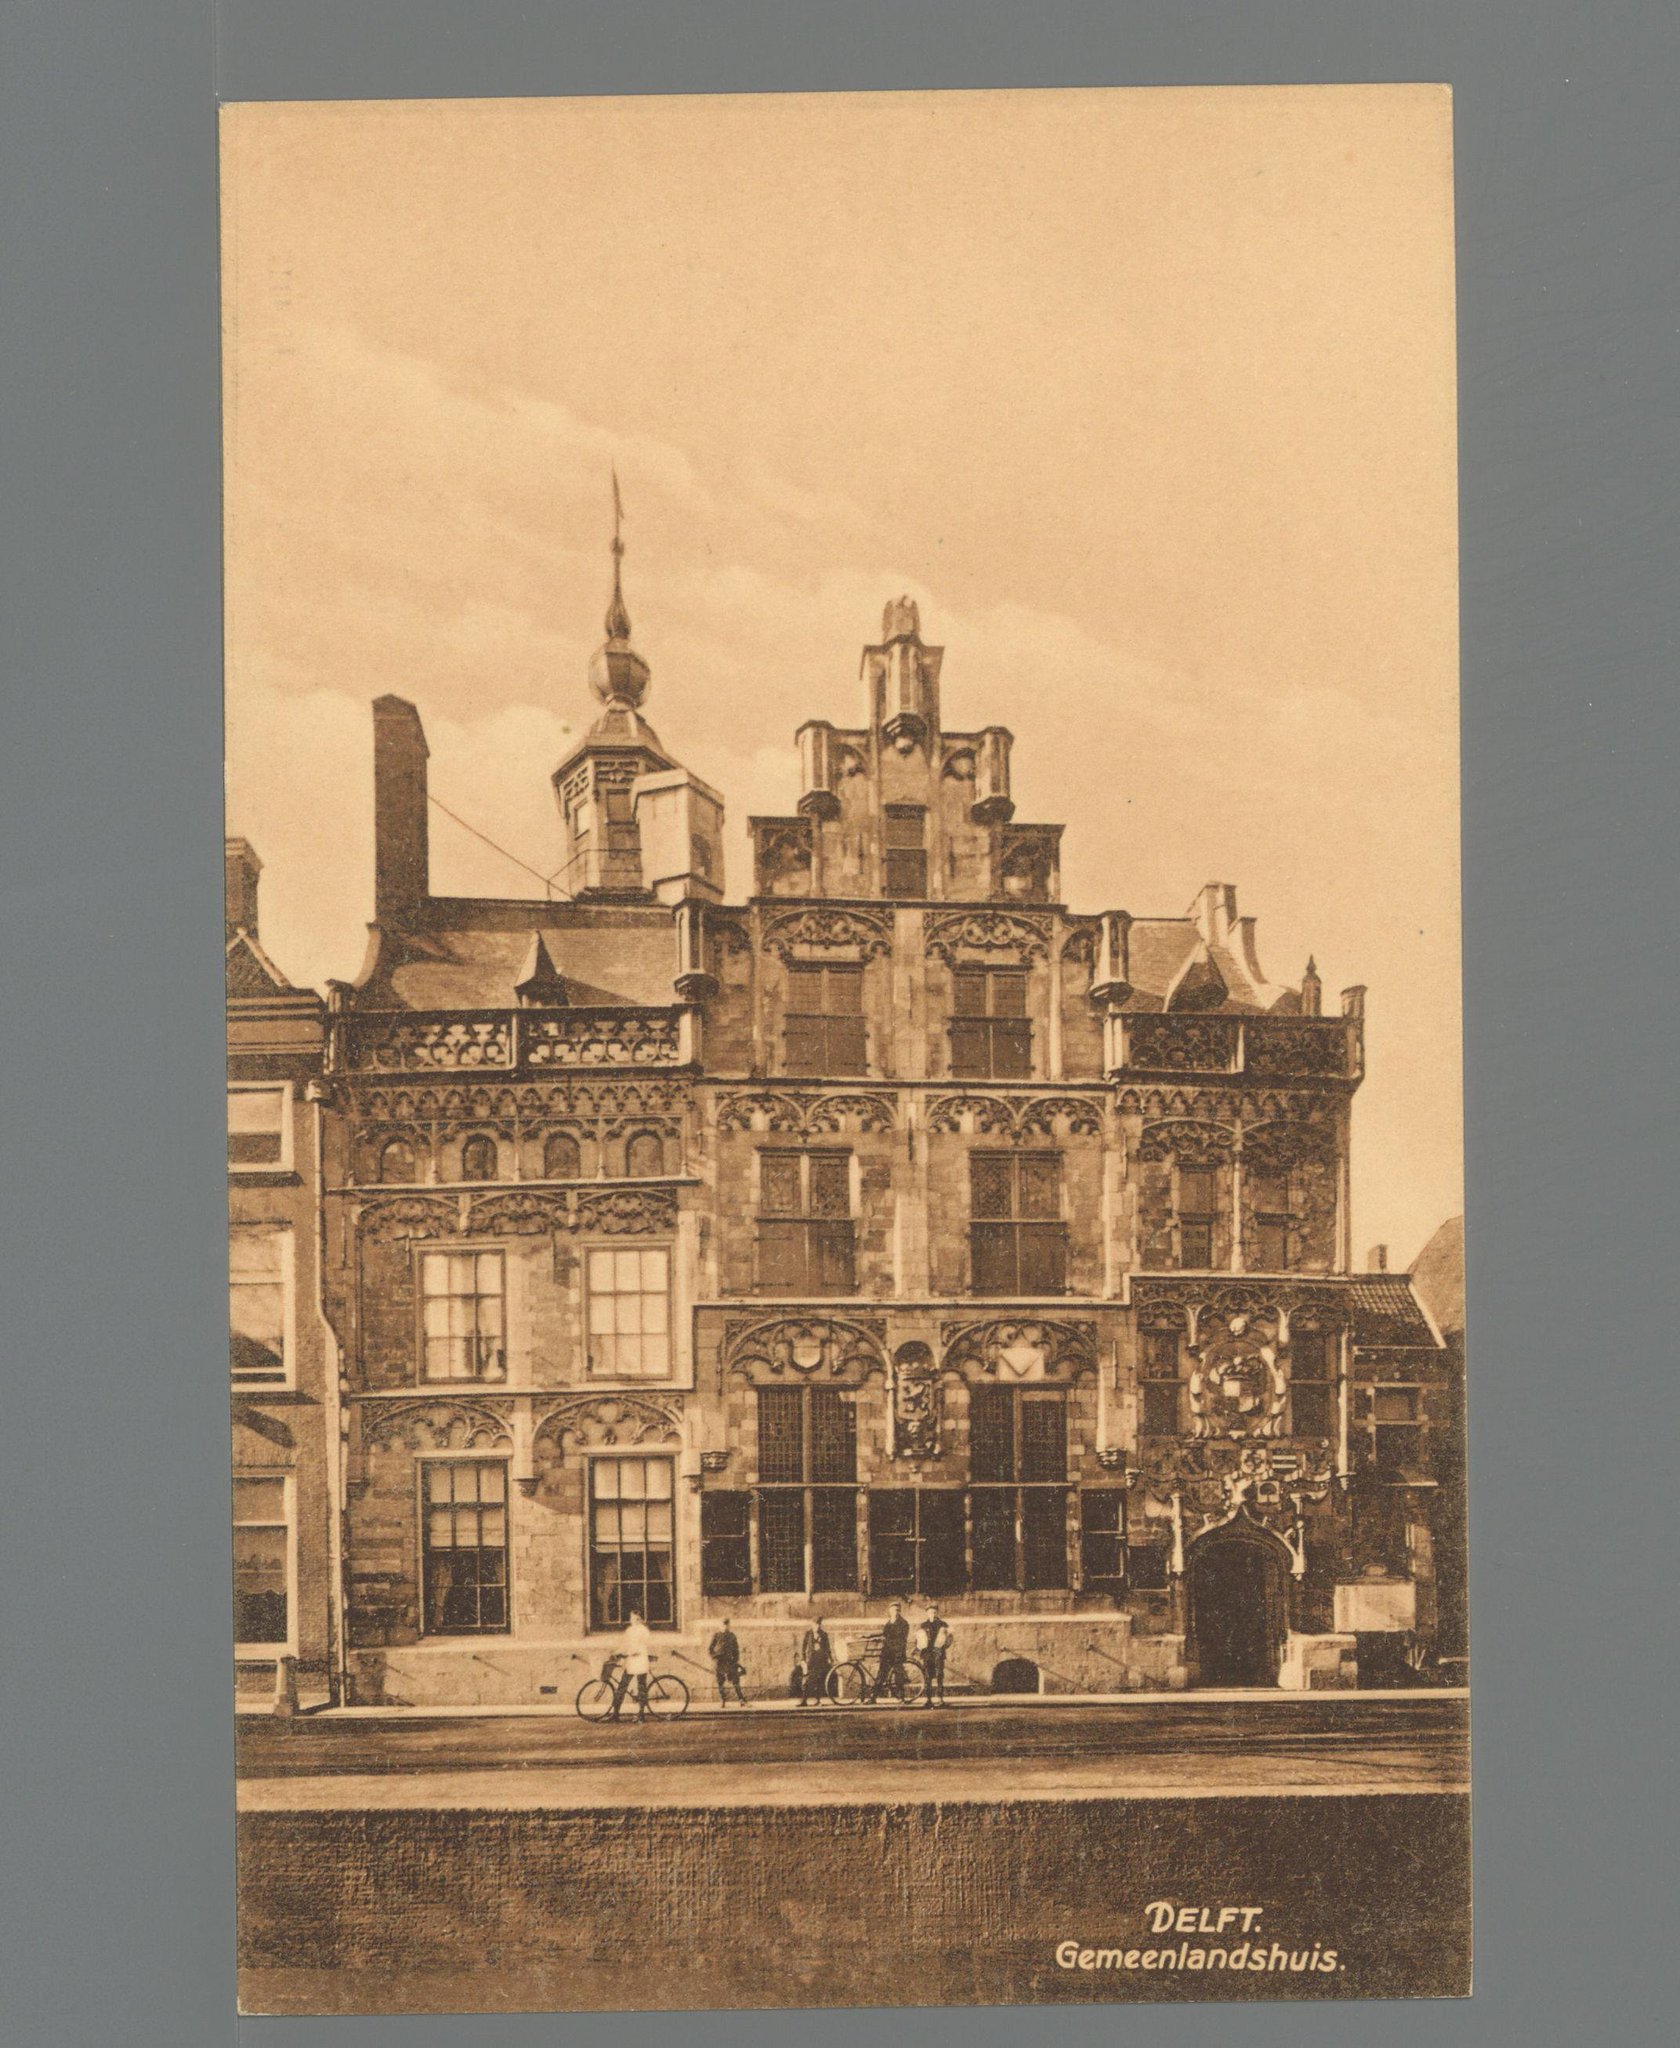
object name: photomechanical print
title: Delft. Gemeenlandshuis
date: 1911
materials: cardboard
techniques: photograph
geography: delft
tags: façade (of house or building)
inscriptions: date